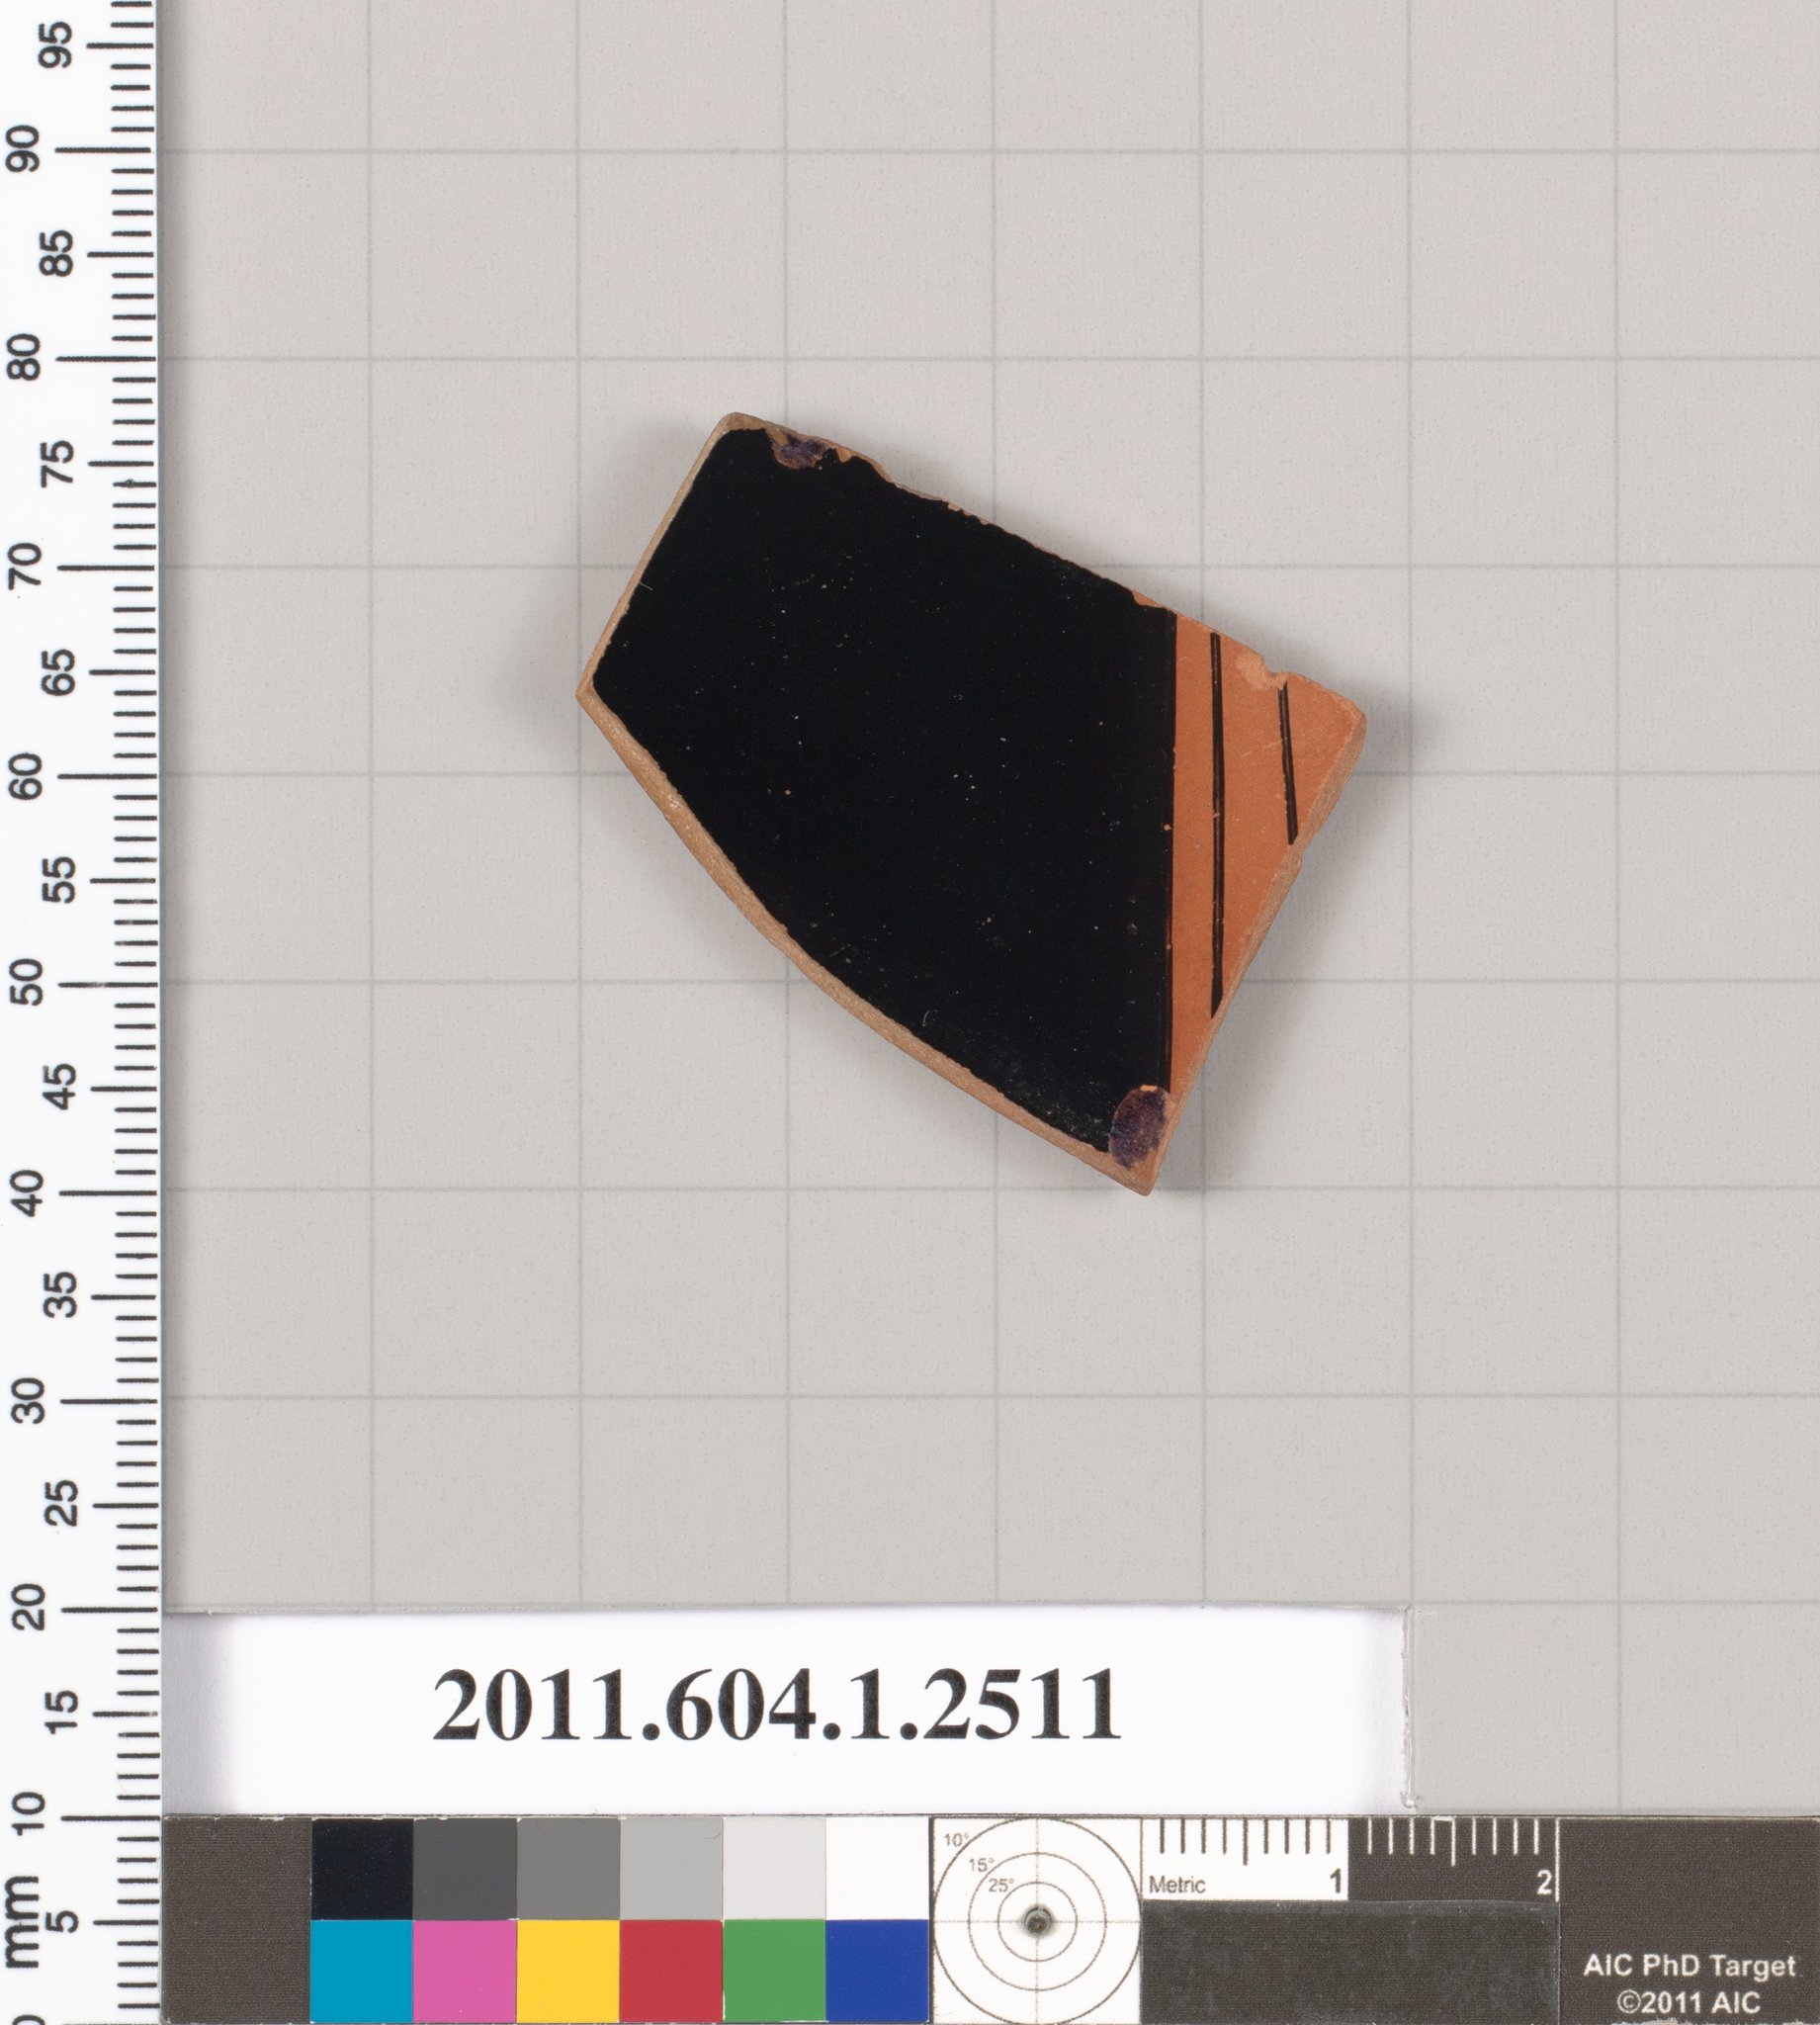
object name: kylix fragment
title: Terracotta fragment of a kylix (drinking cup)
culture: greek, attic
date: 490-480 BCE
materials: terracotta